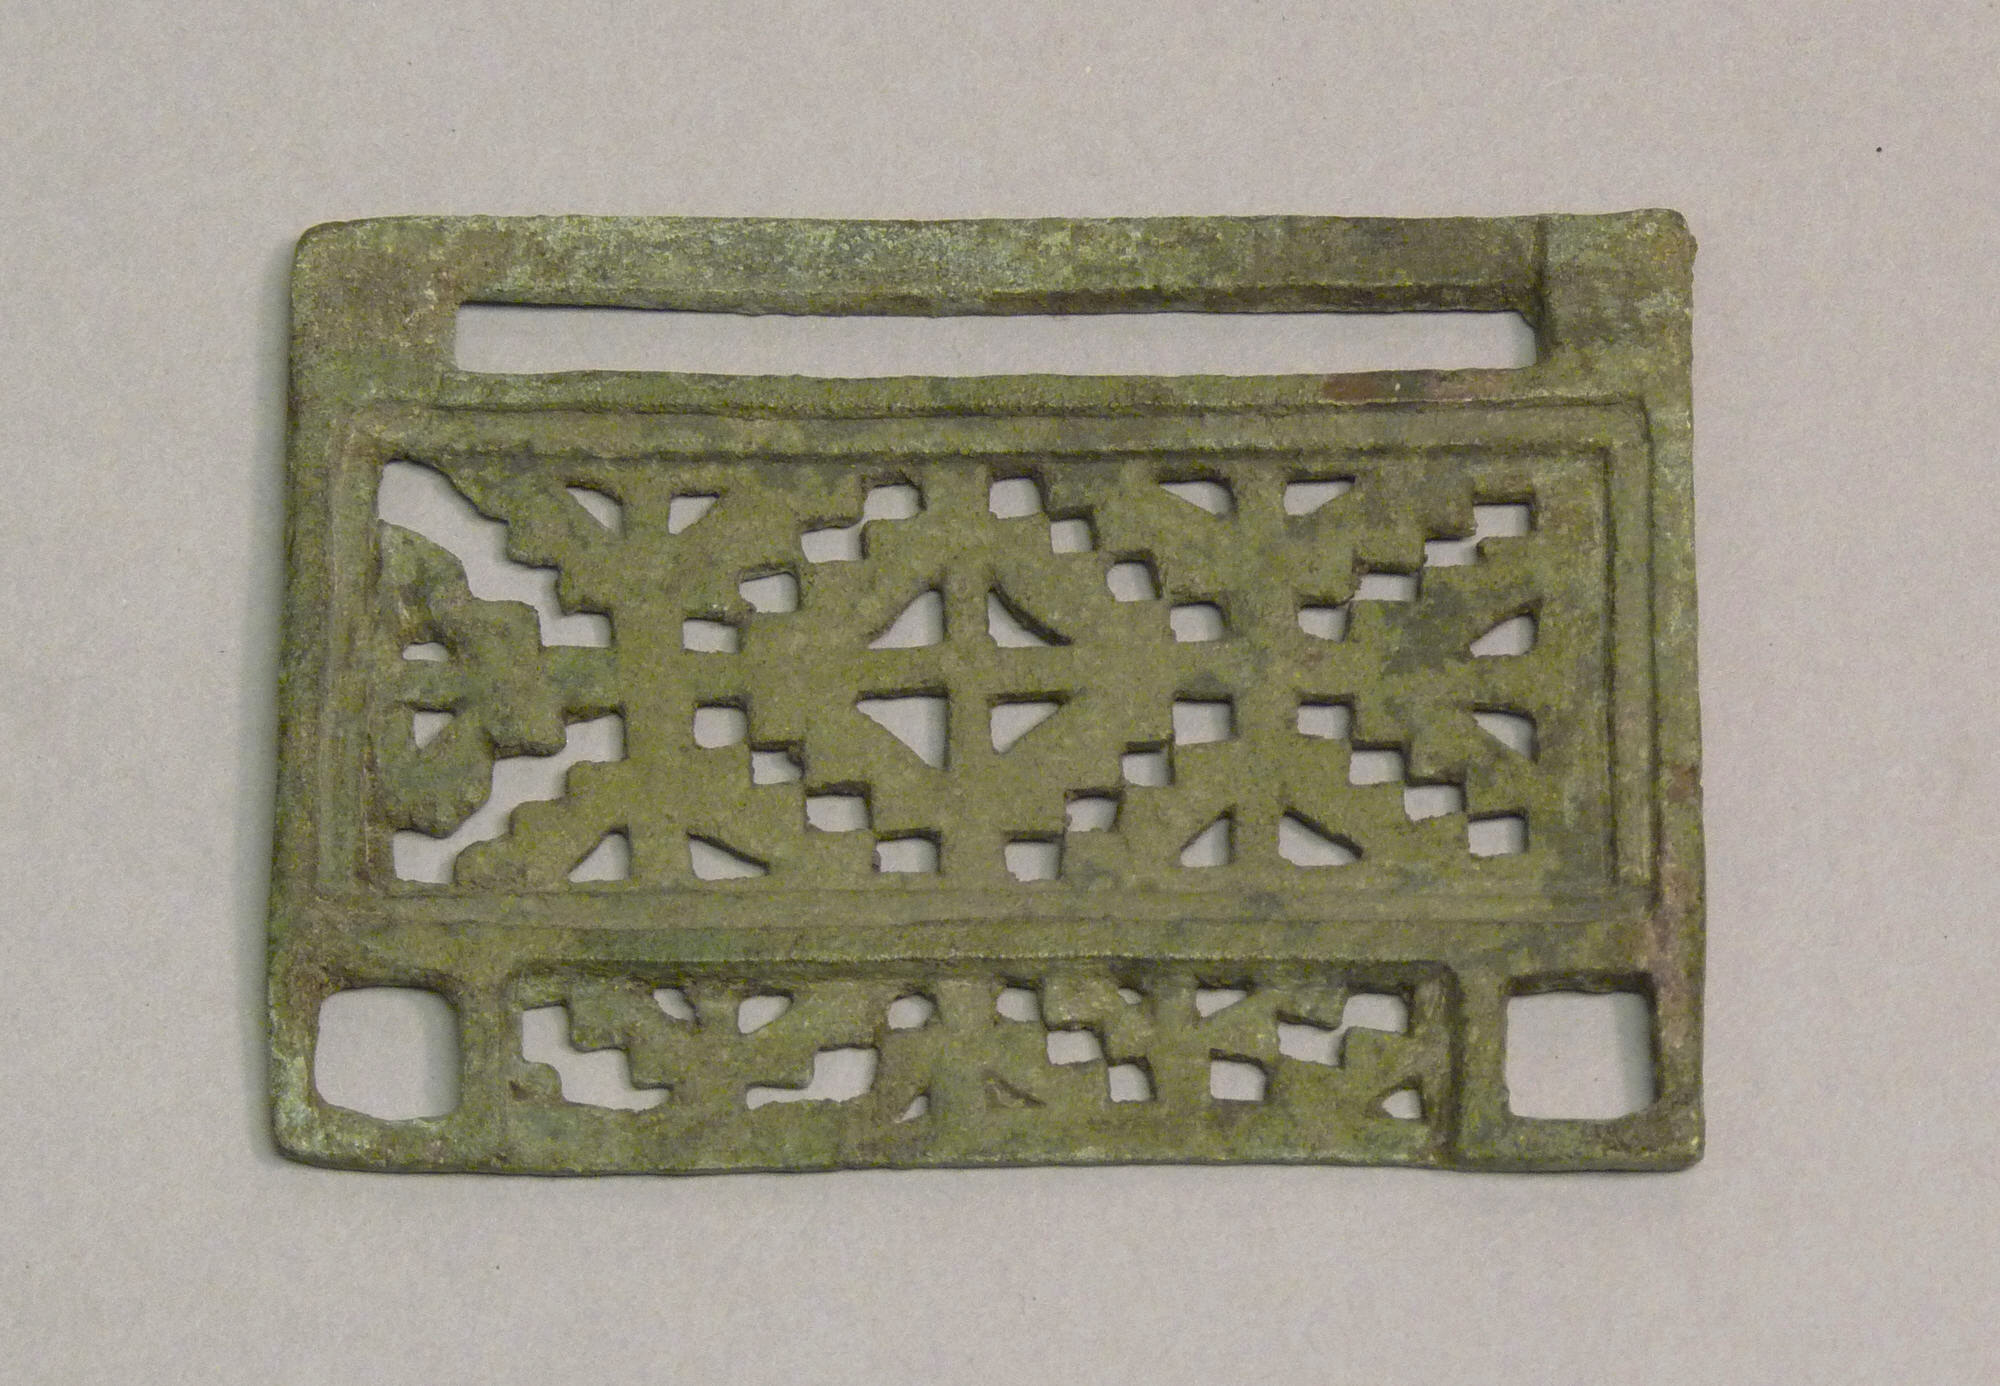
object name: buckle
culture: vietnamese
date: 500 BCE-300 CE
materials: bronze